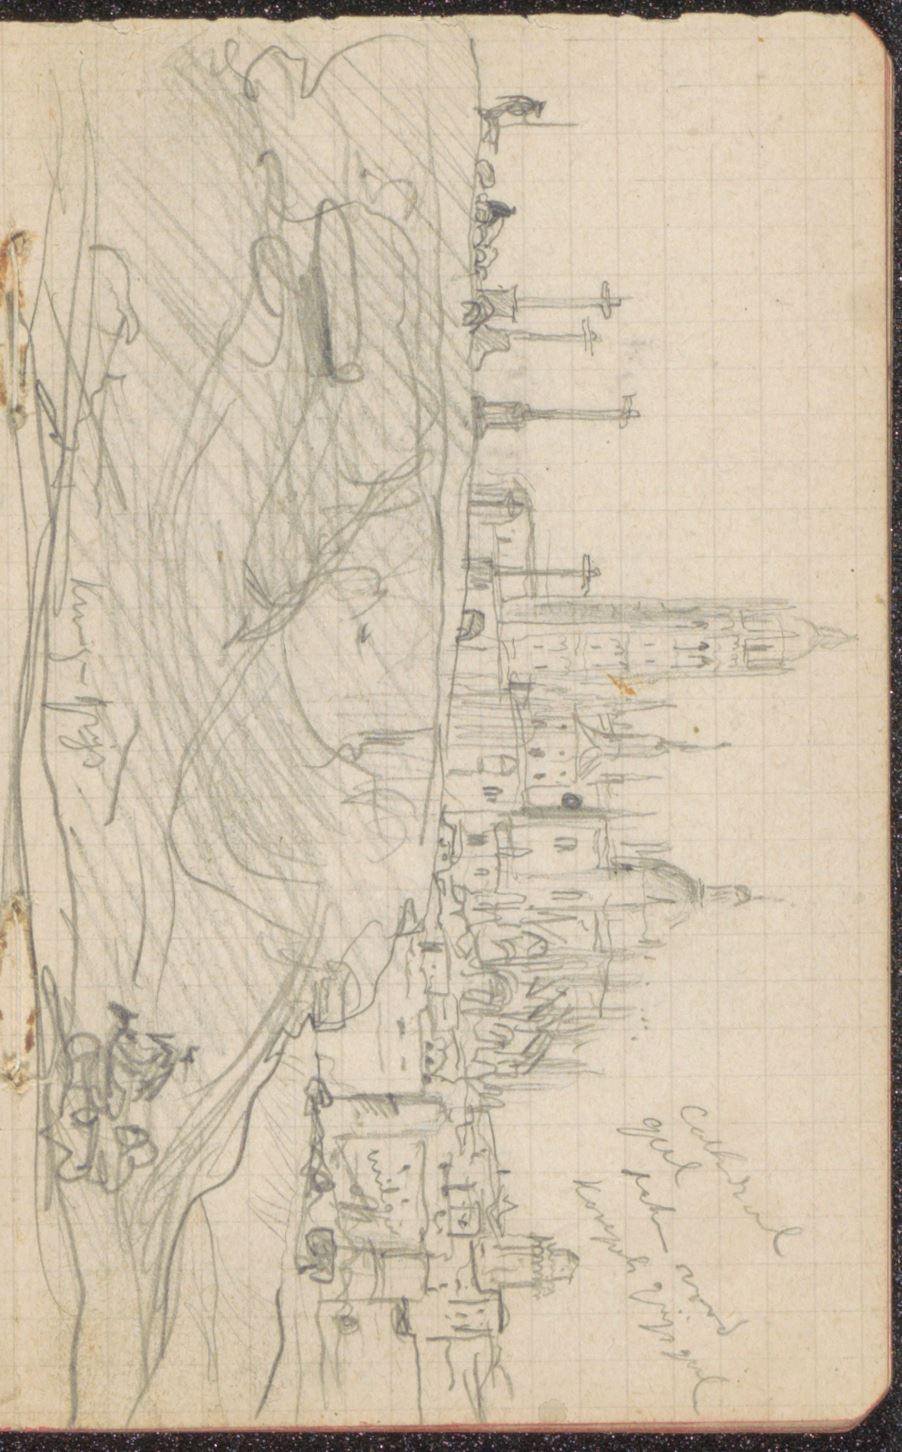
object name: sketchbook leaf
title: Gezicht op een stad op een heuveltop, mogelijk Segovia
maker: marius bauer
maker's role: draughtsman, print maker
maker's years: 1867-1932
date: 1902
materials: pencil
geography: segovia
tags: city-view, and landscape with man-made constructions, tower, clock tower ~ monumental adornment, (high) hill, churchyard, cemetery, dome ~ architecture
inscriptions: kleurnotitie, handgeschreven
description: Op de heuvel zijn kruizen te zien, vermoedelijk van een begraafplaats. Pagina 11 uit een schetsboek met 23 bladen.